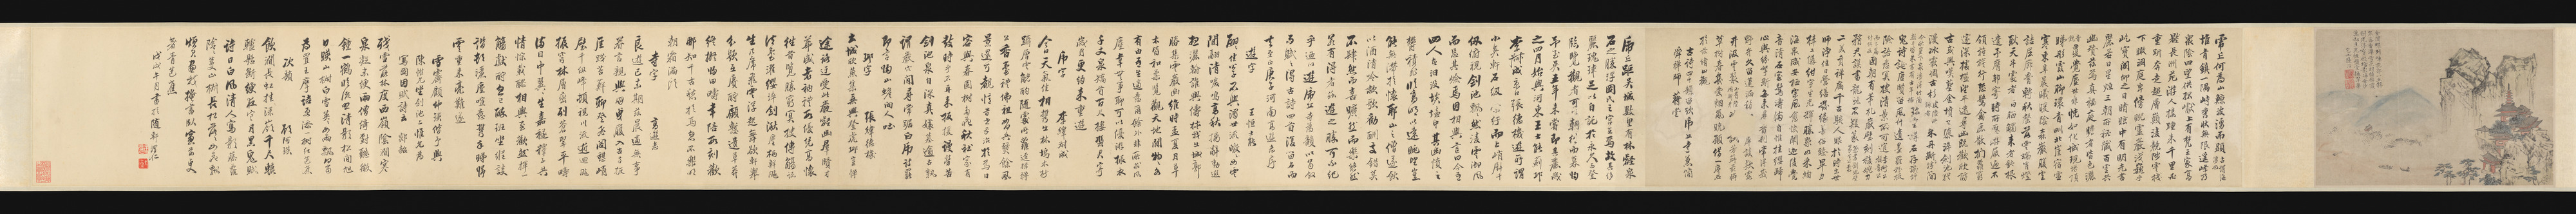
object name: handscroll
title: Tiger Hill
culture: chinese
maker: lu zhi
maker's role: artist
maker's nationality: chinese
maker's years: 1495-1576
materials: ink, paper